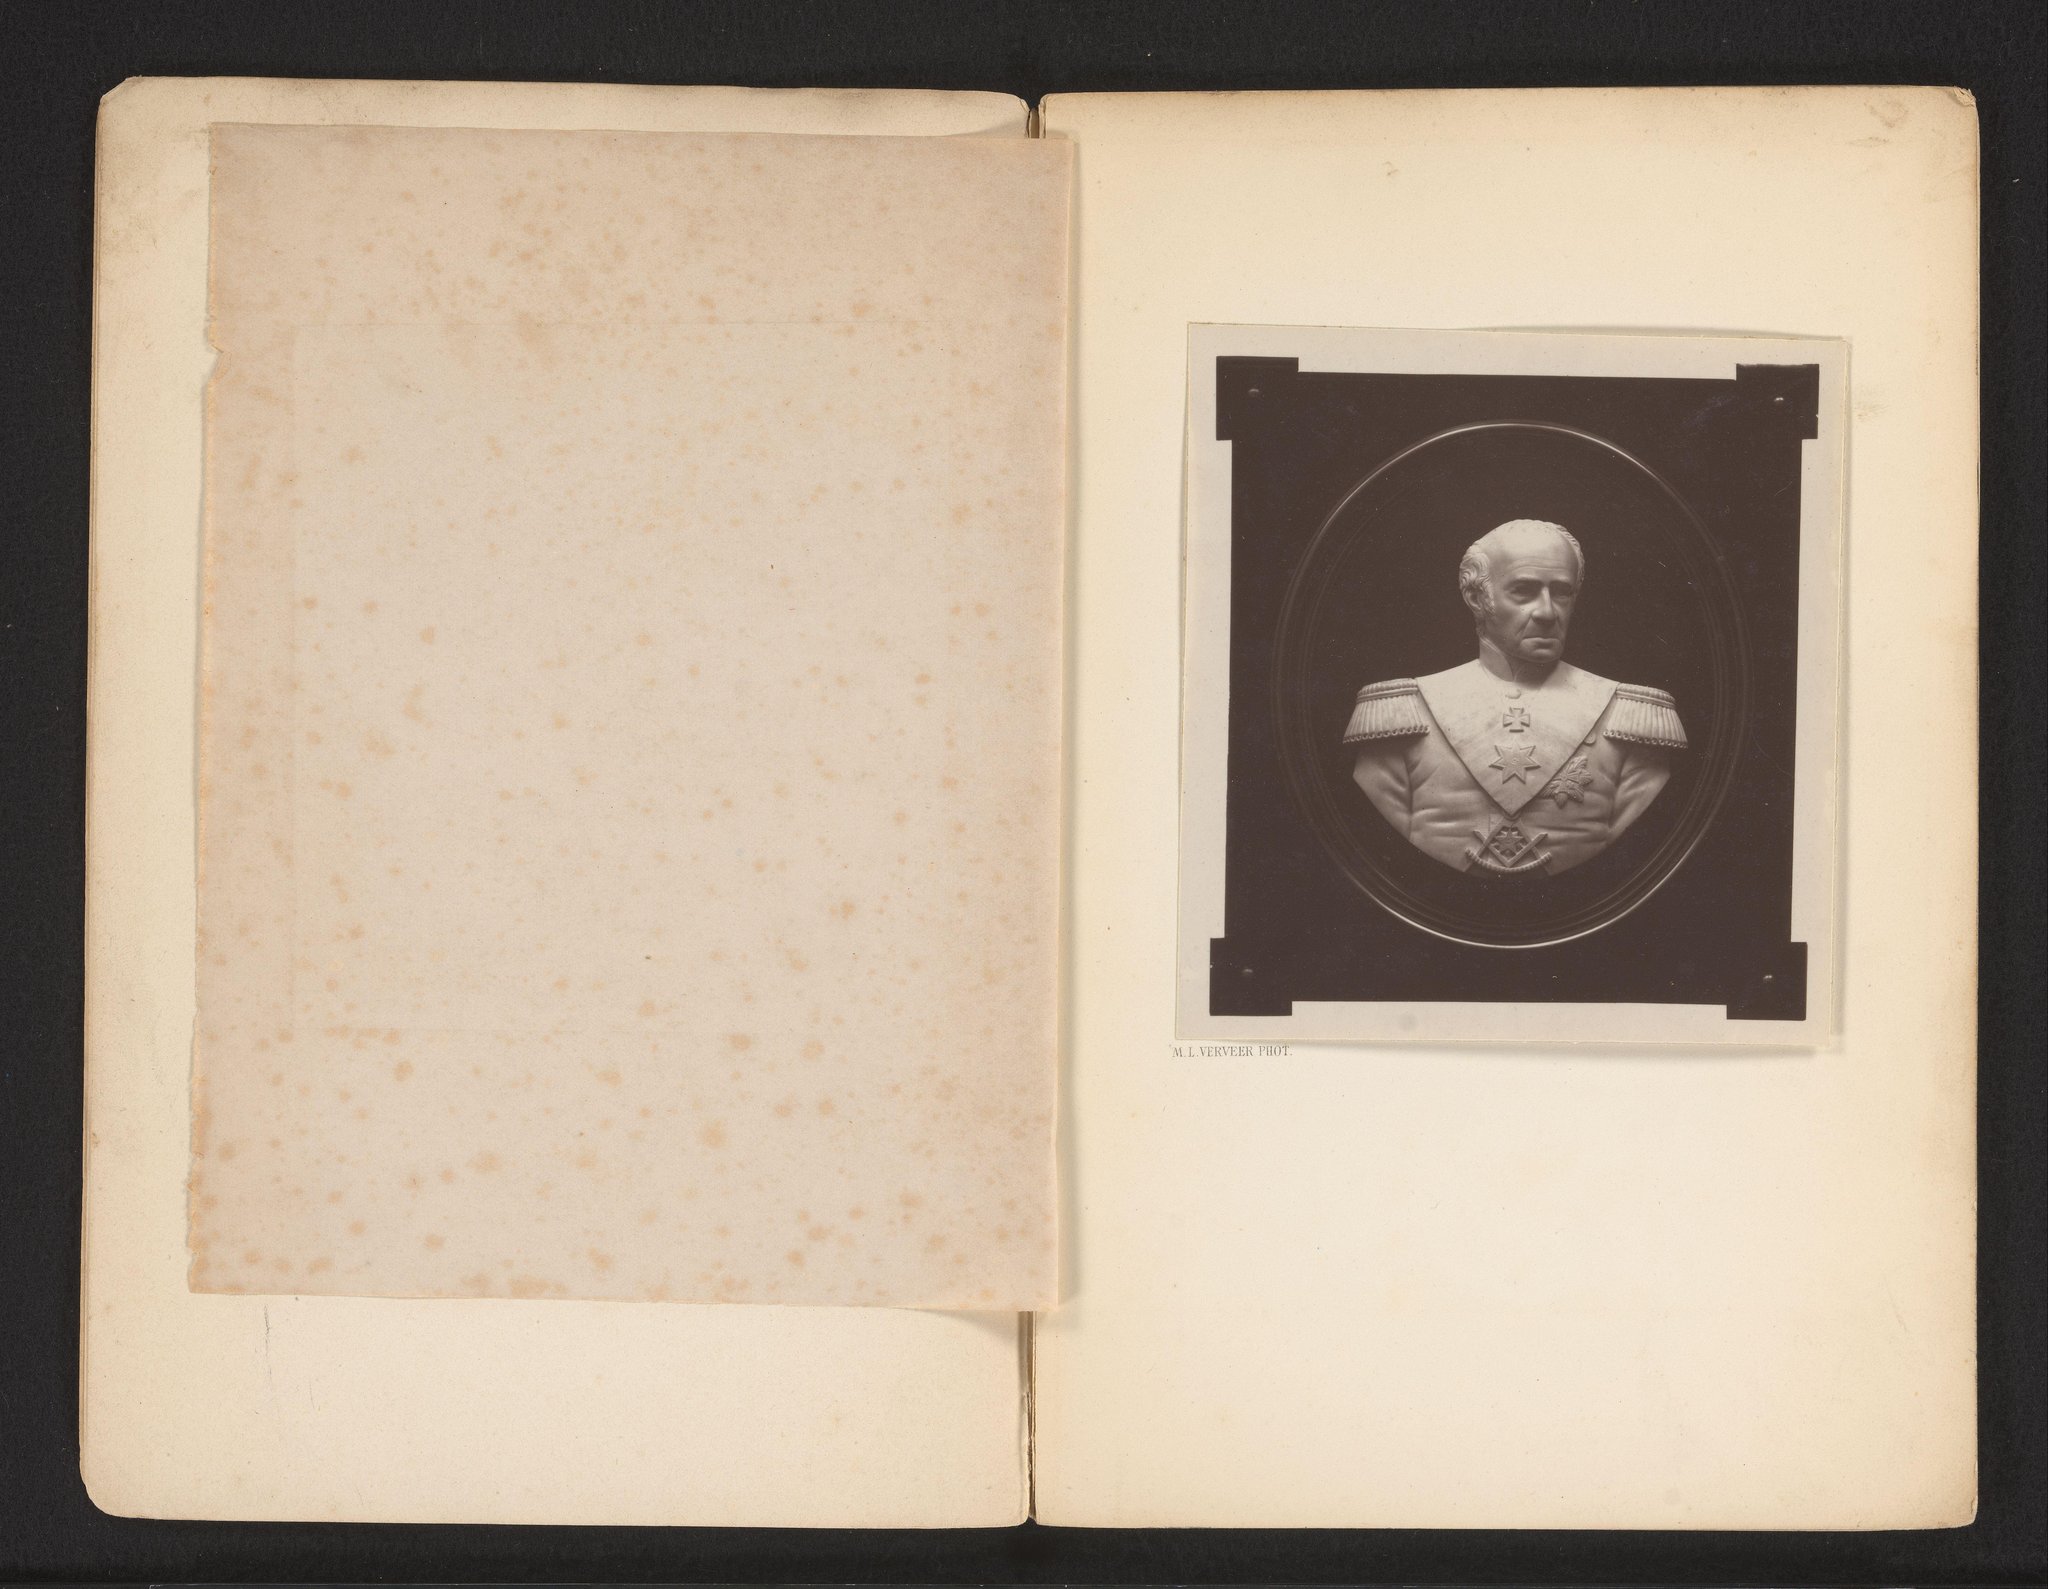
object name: photomechanical print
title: Buste van Frederik, prins der Nederlanden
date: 1876-1881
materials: paper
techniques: woodburytype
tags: berlin, prince, piece of sculpture, reproduction of a piece of sculpture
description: Prent op tweede ongenummerde pagina voor pagina 5.